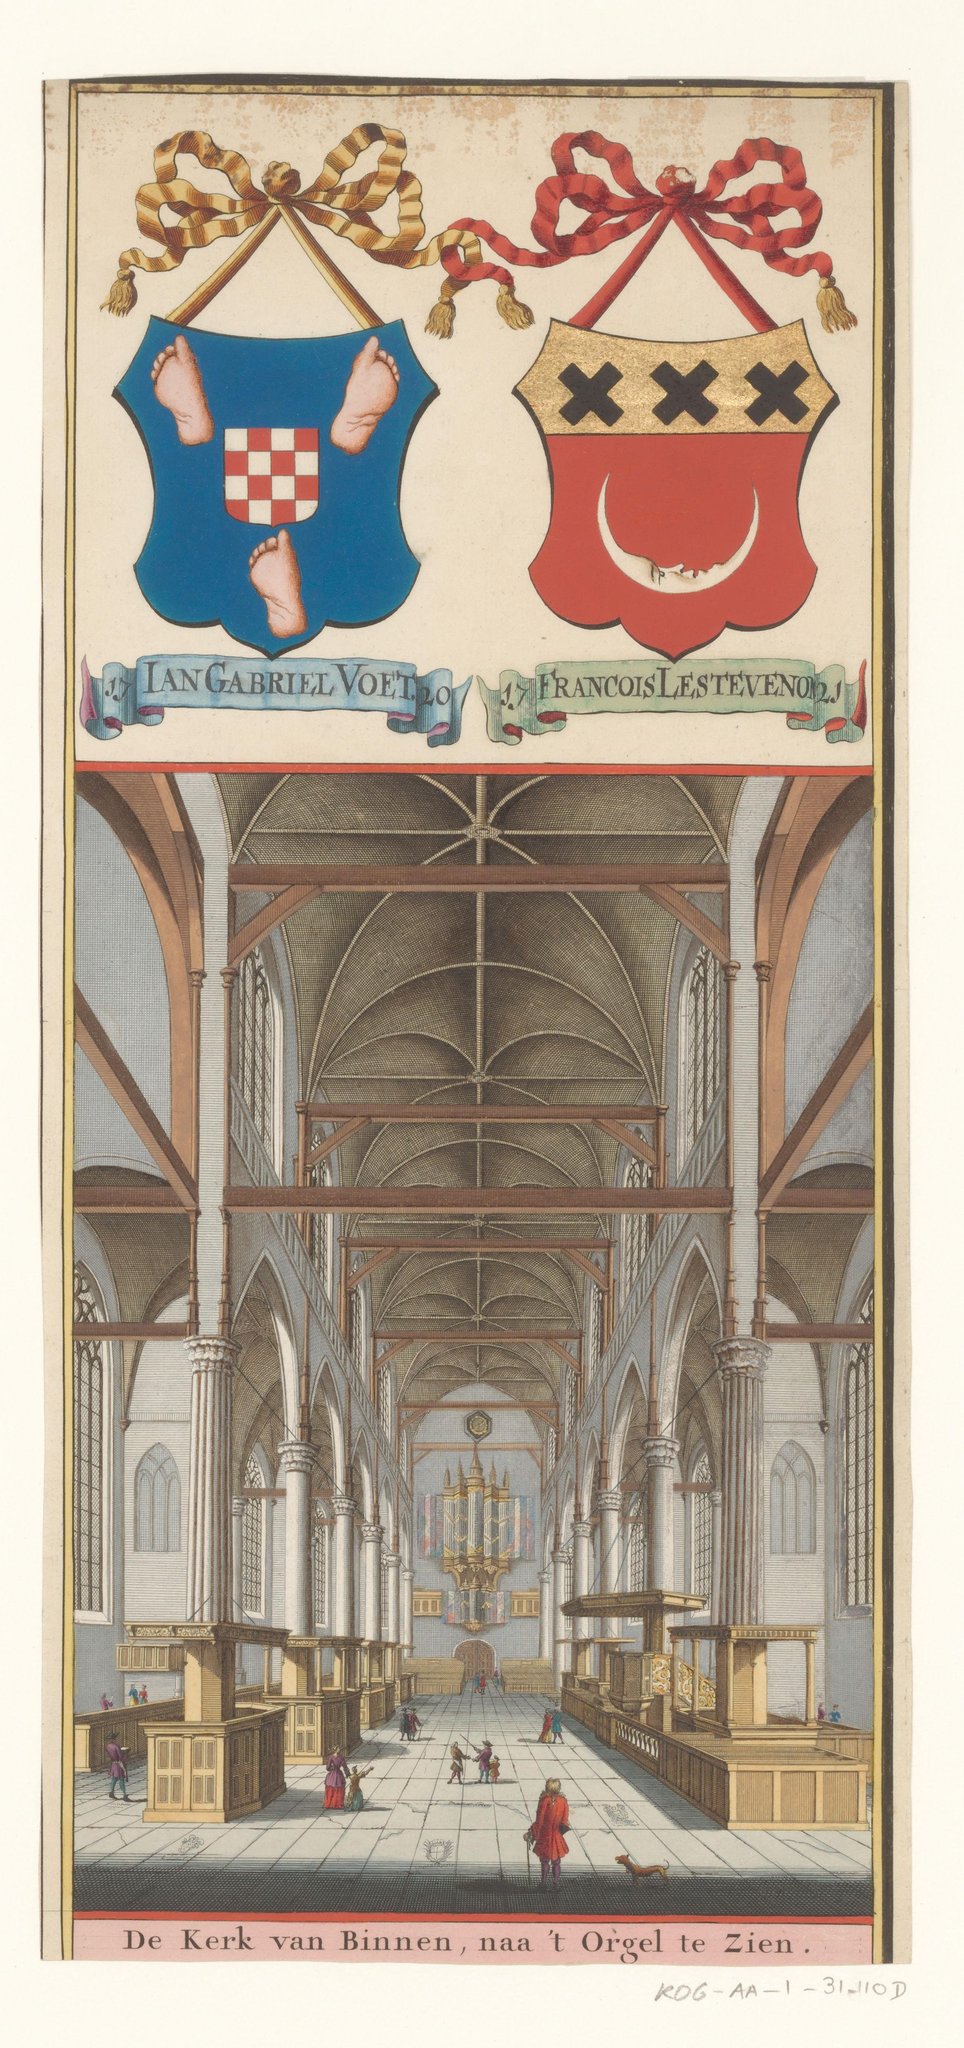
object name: print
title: Interieur van de Oude Kerk te Amsterdam gezien richting het orgel, en twee wapenschilden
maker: daniël stopendaal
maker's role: print maker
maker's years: 1672-1726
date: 1685-1726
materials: paper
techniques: engraving, etching, hand coloring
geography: amsterdam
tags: armorial bearing, heraldry (...) - device, motto, church organ, interior of church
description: Waarschijnlijk oorspronkelijk een van de randprenten van 'Caart vande Sitplaat-zen inde Oude-Kerk', een plattegrond van de zitplaatsen in de Oude Kerk. Daniël Stopendaal staat als prentmaker vermeld op de plattegrond zelf, de randprenten zijn mogelijk ook door hem gemaakt. Zie RP-P-AO-23-57 voor een soortgelijke plattegrond van de Oosterkerk met randprenten.